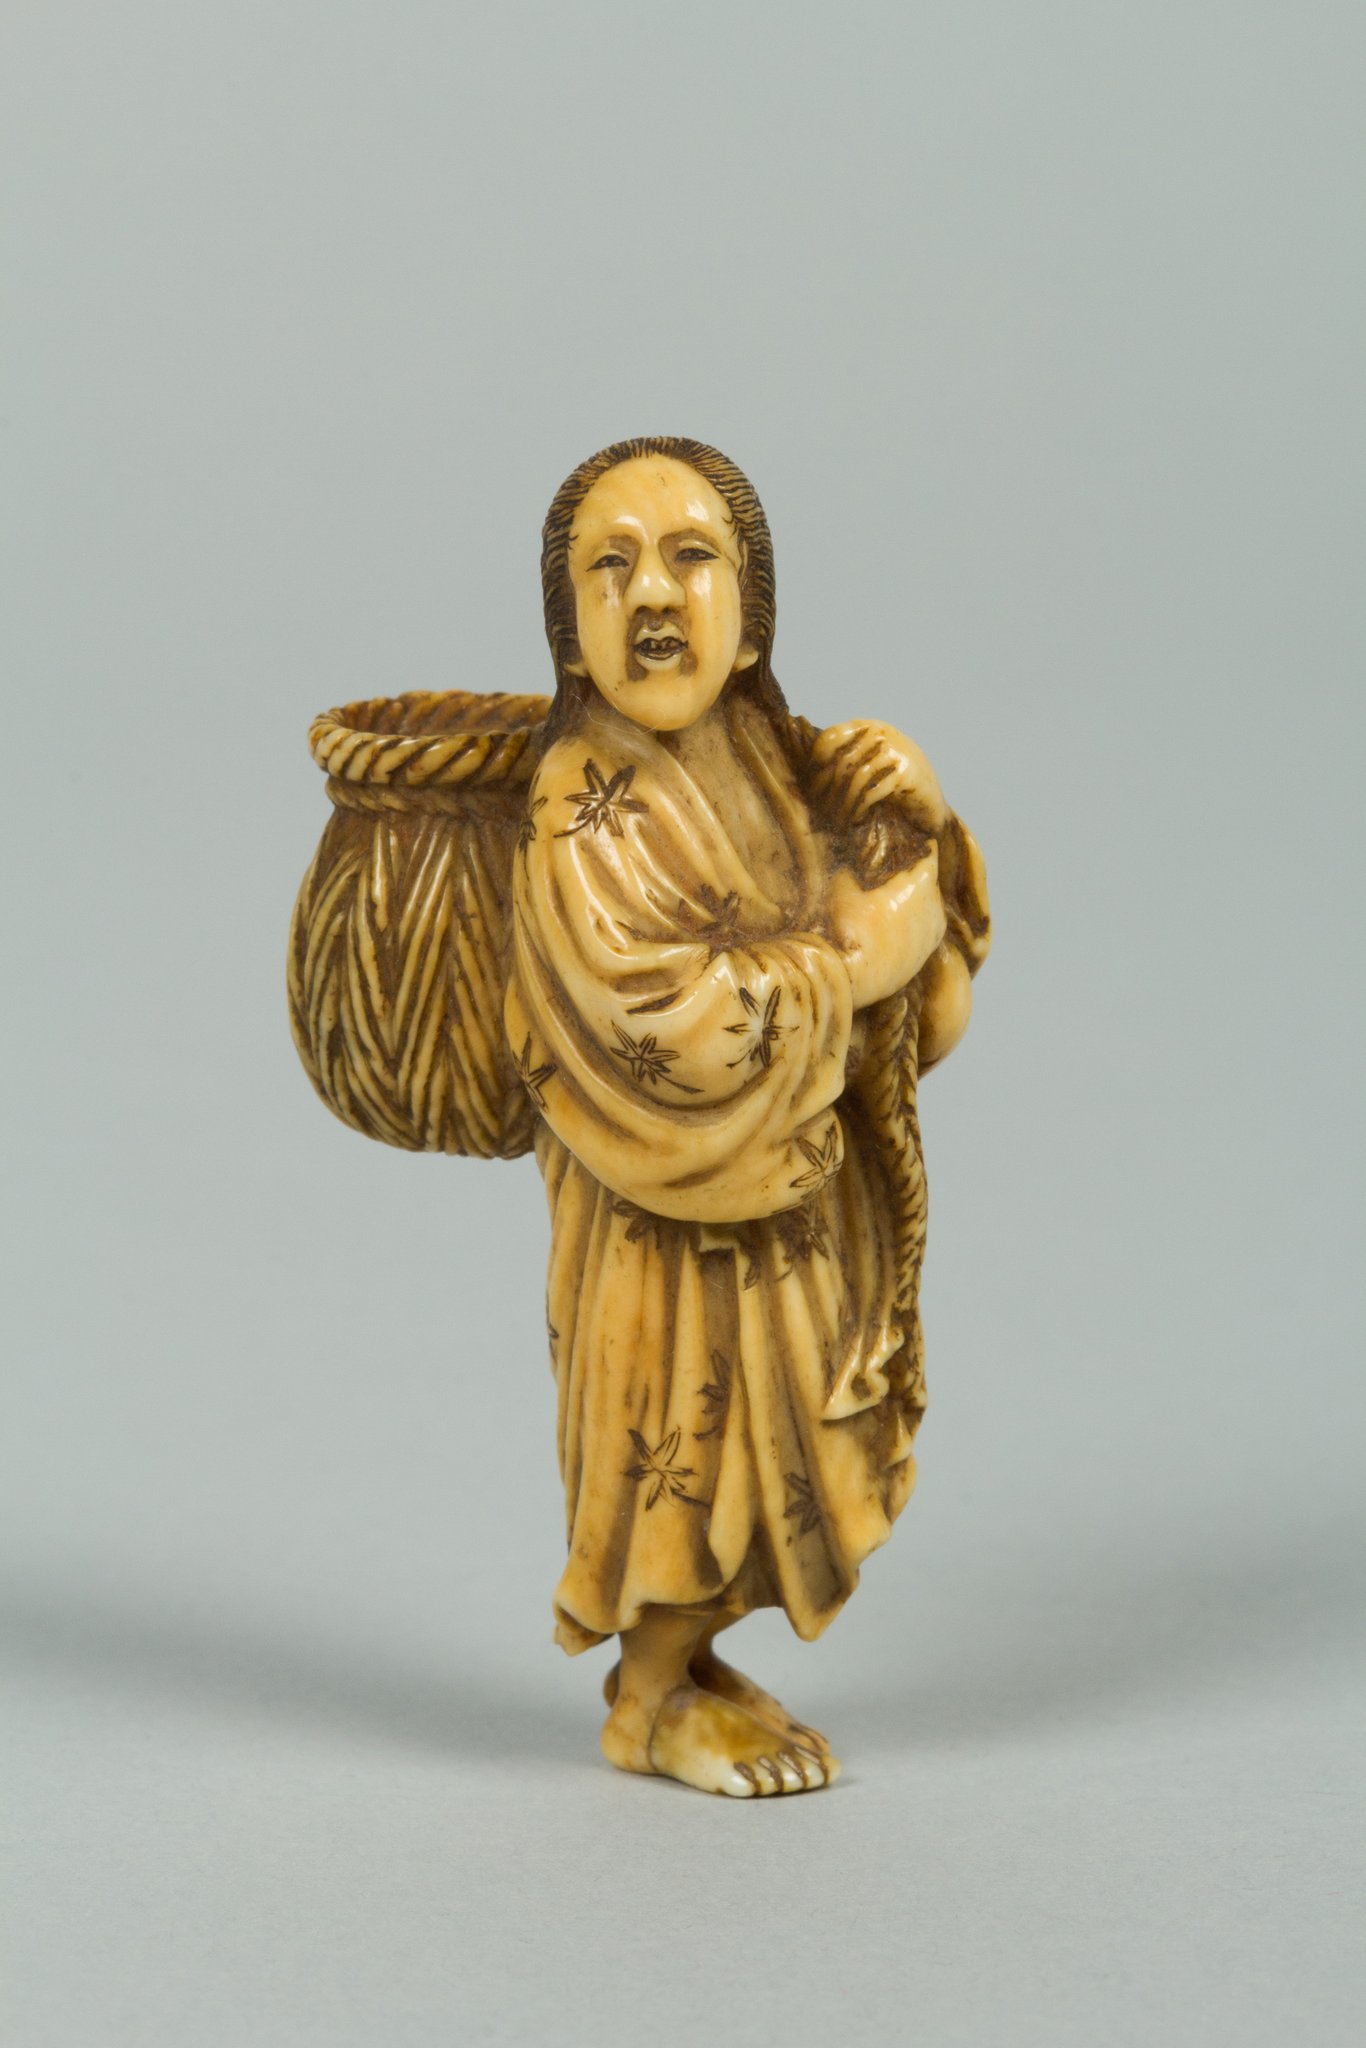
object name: netsuke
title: Netsuke of a Girl Carrying a Basket on her Back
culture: japanese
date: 1801-1900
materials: ivory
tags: girls,baskets